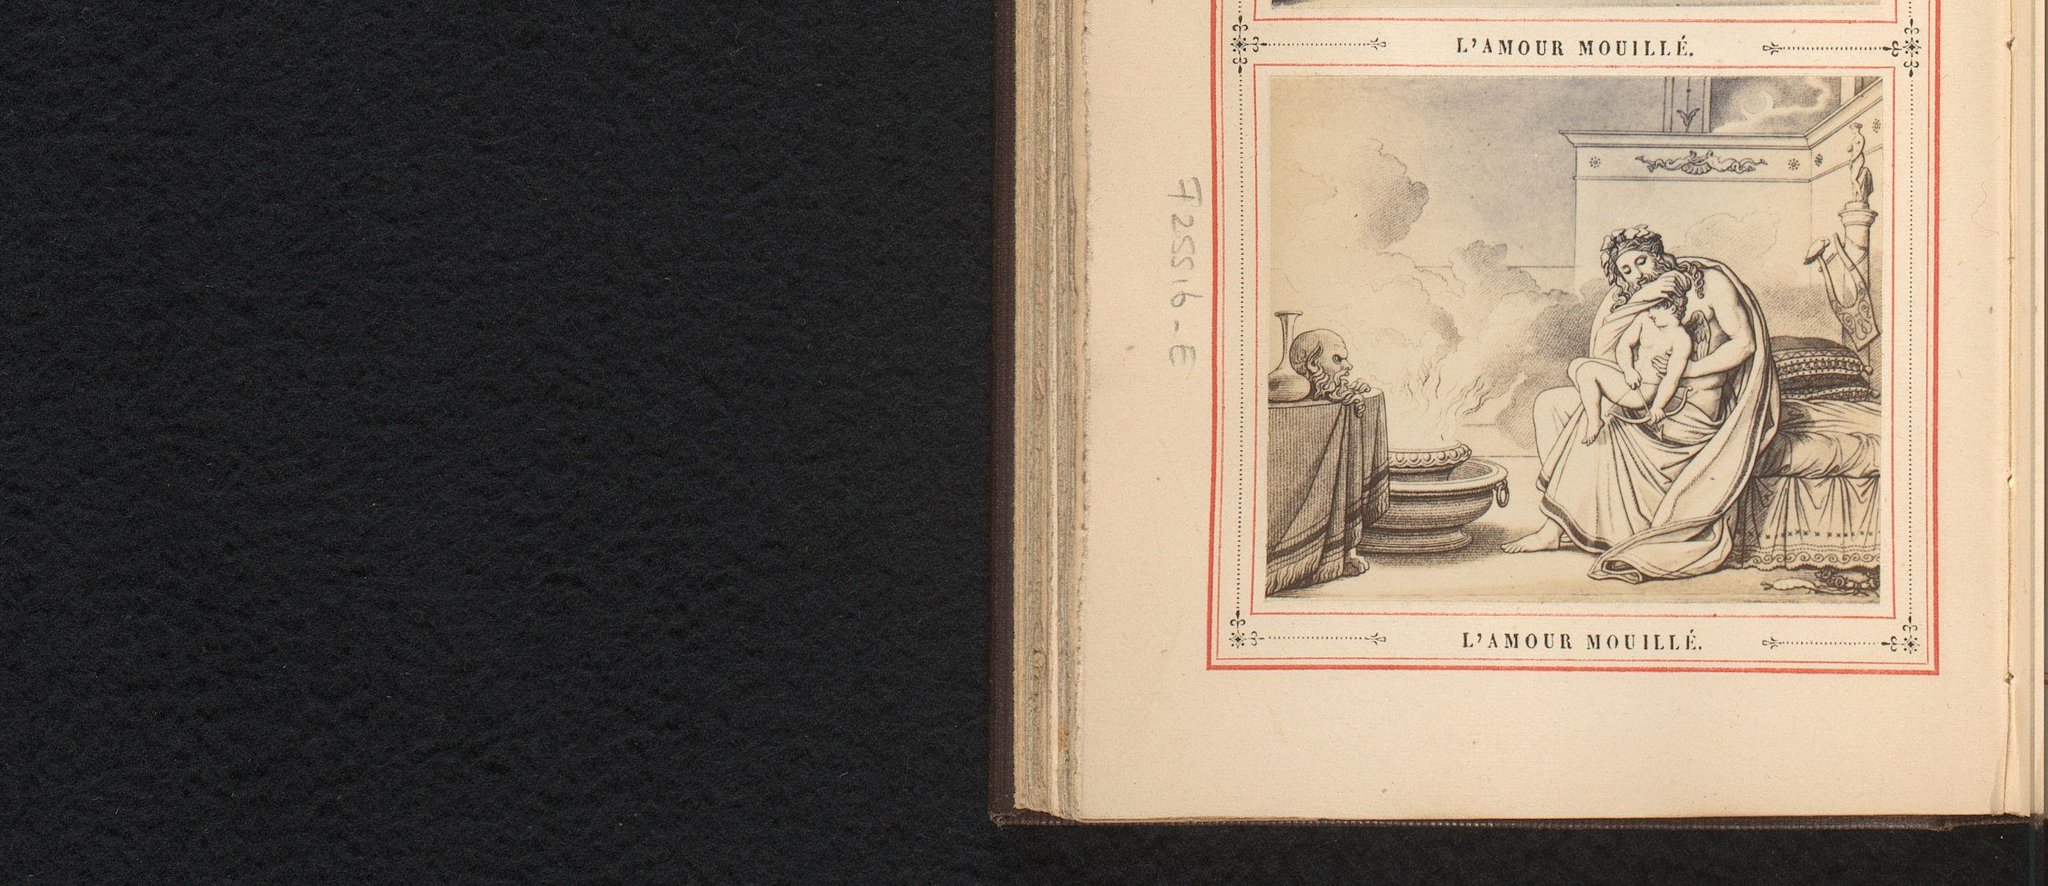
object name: reproduction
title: Fotoreproductie van een tekening van Girodet, god met kind, illustratie bij Apothéose d'Anacréon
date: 1859-1864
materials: paper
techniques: albumen print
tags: gods ~ classical mythology